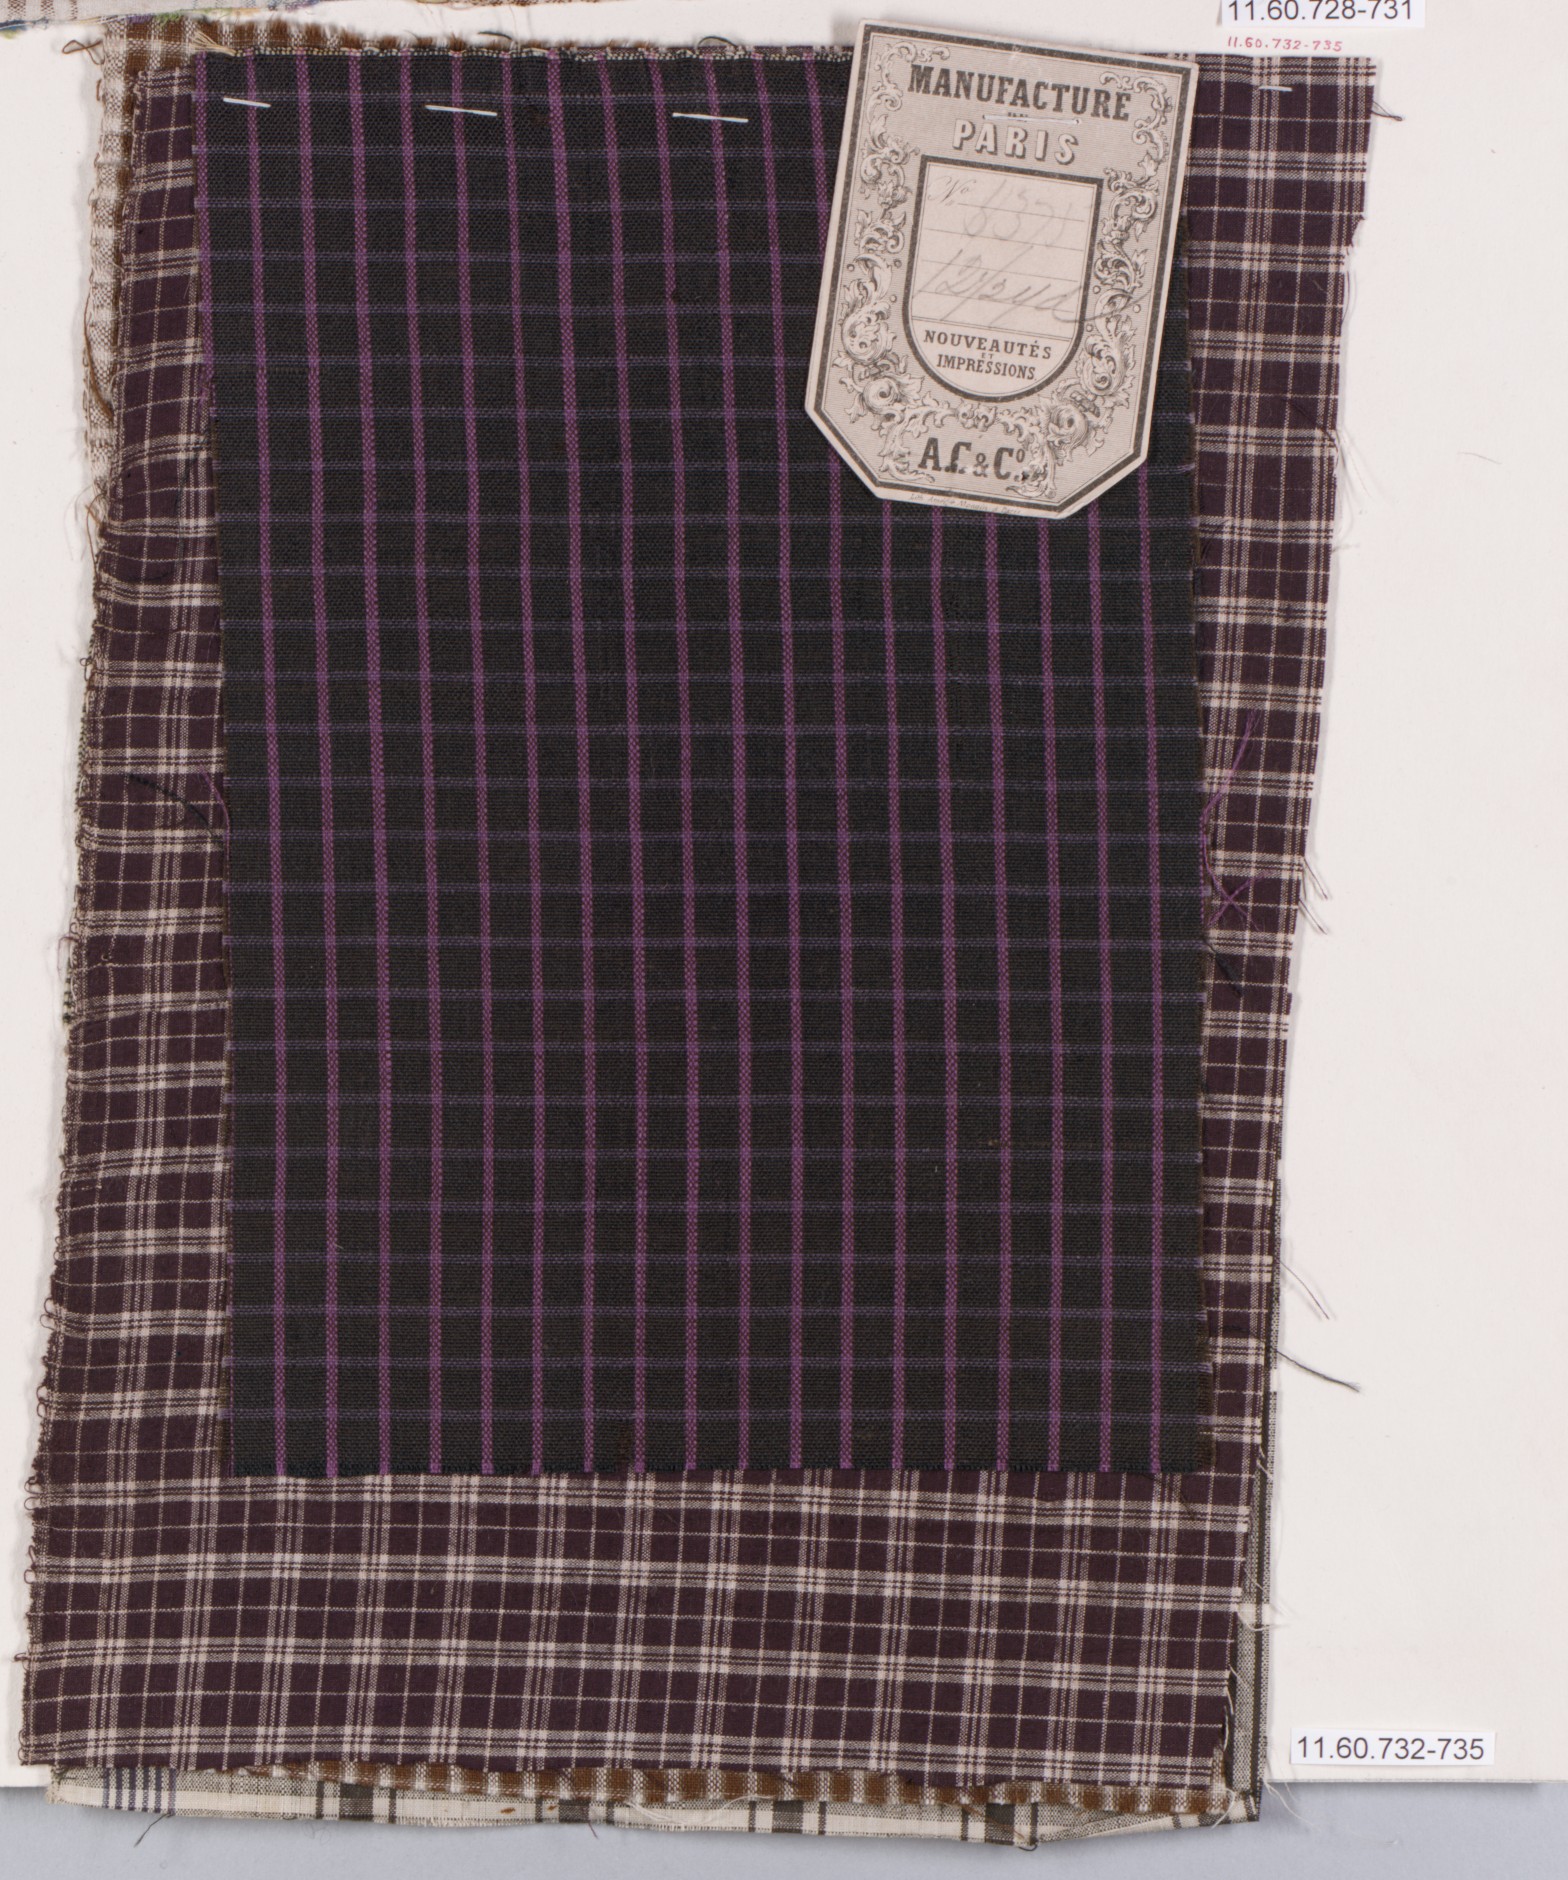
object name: sample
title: Samples (4)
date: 1834-1866